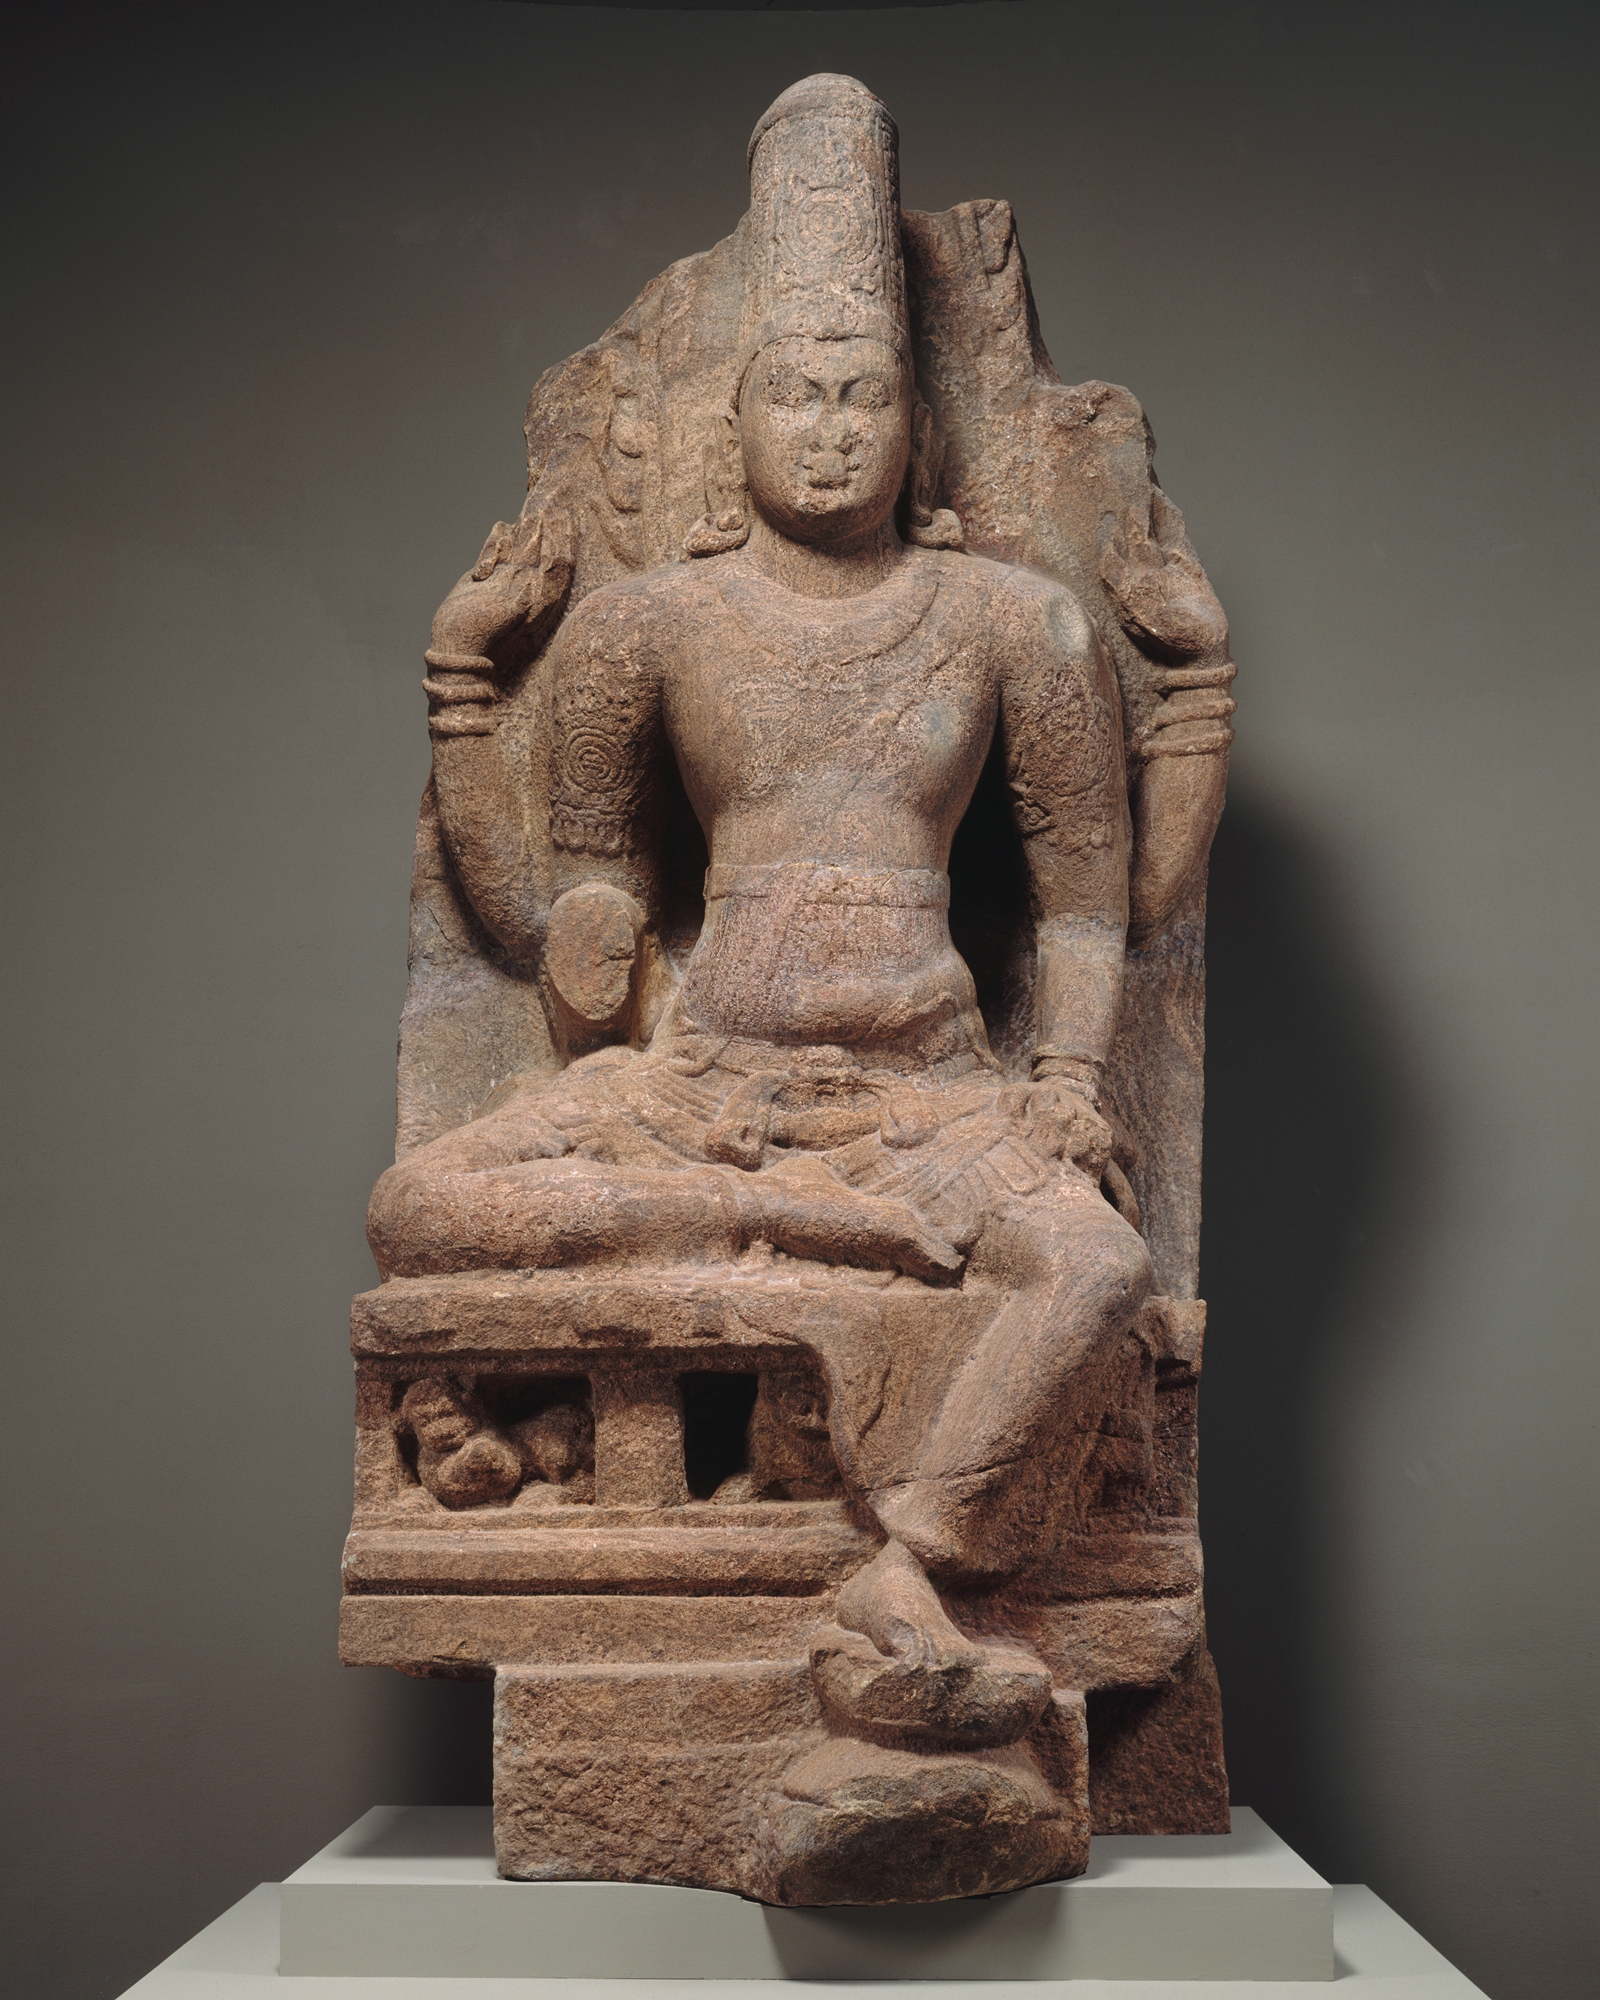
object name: statue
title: Enthroned Vishnu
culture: indian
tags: vishnu,hinduism